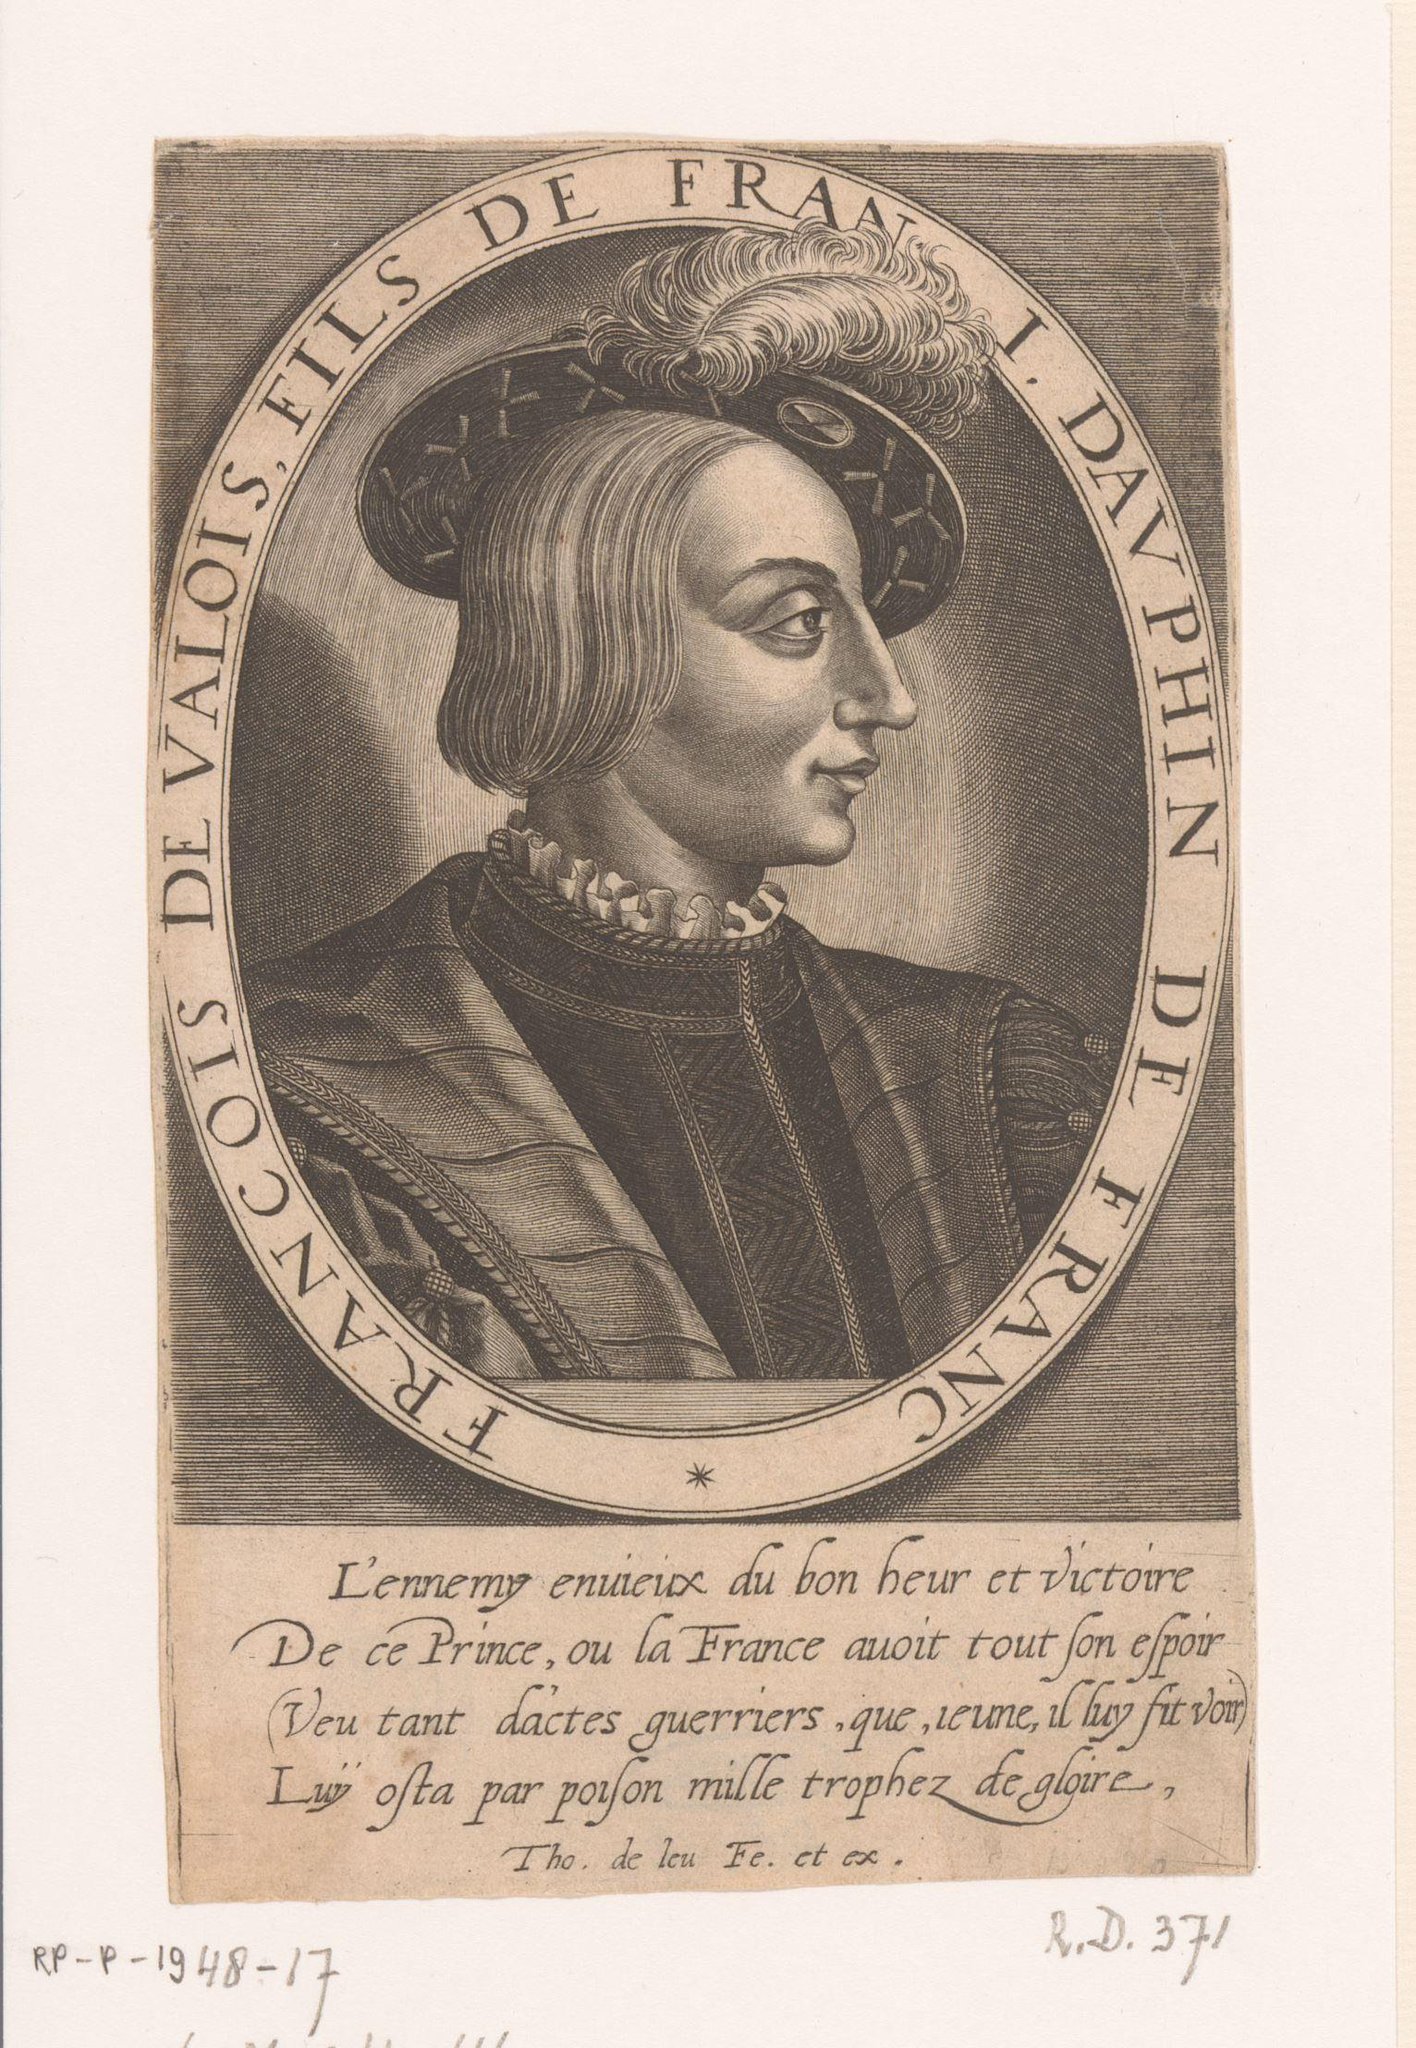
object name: print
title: Portret van Frans III, hertog van Bretagne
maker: thomas de leu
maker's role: print maker, publisher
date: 1576-1614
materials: paper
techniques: engraving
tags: historical persons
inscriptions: inscription: ‘P. mariette 1666’, collector's mark: Lugt 151, collector's mark: Lugt 2228